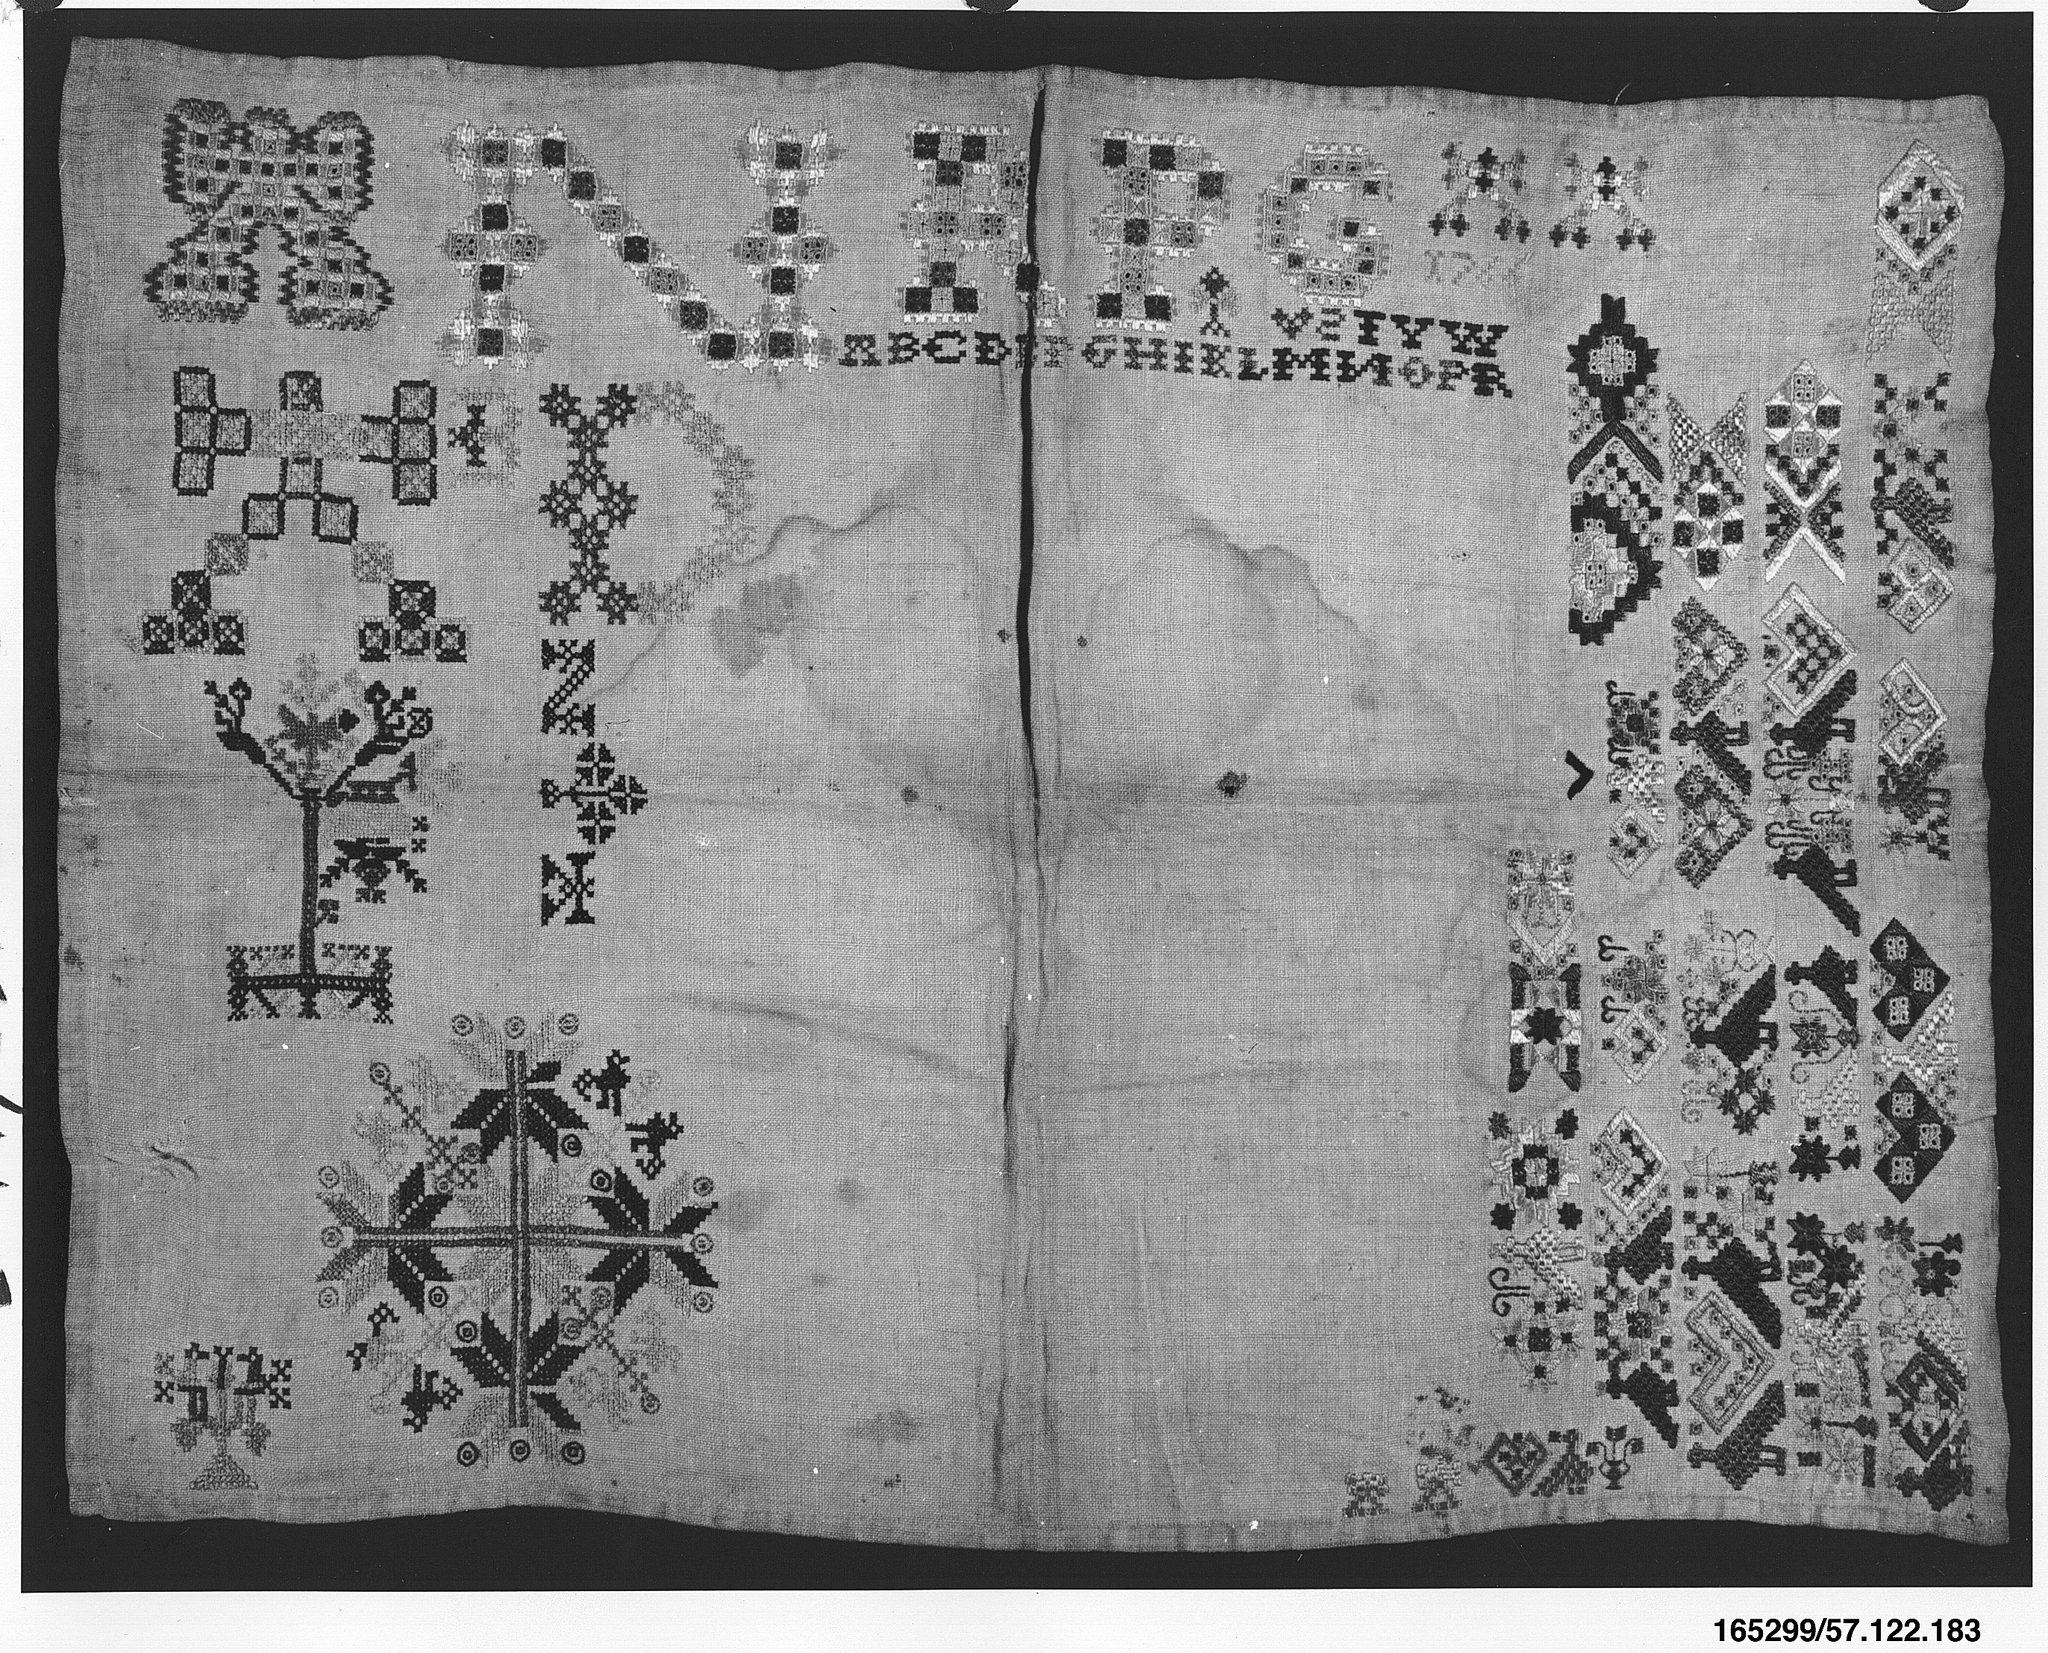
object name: sampler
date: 1766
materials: linen, silk